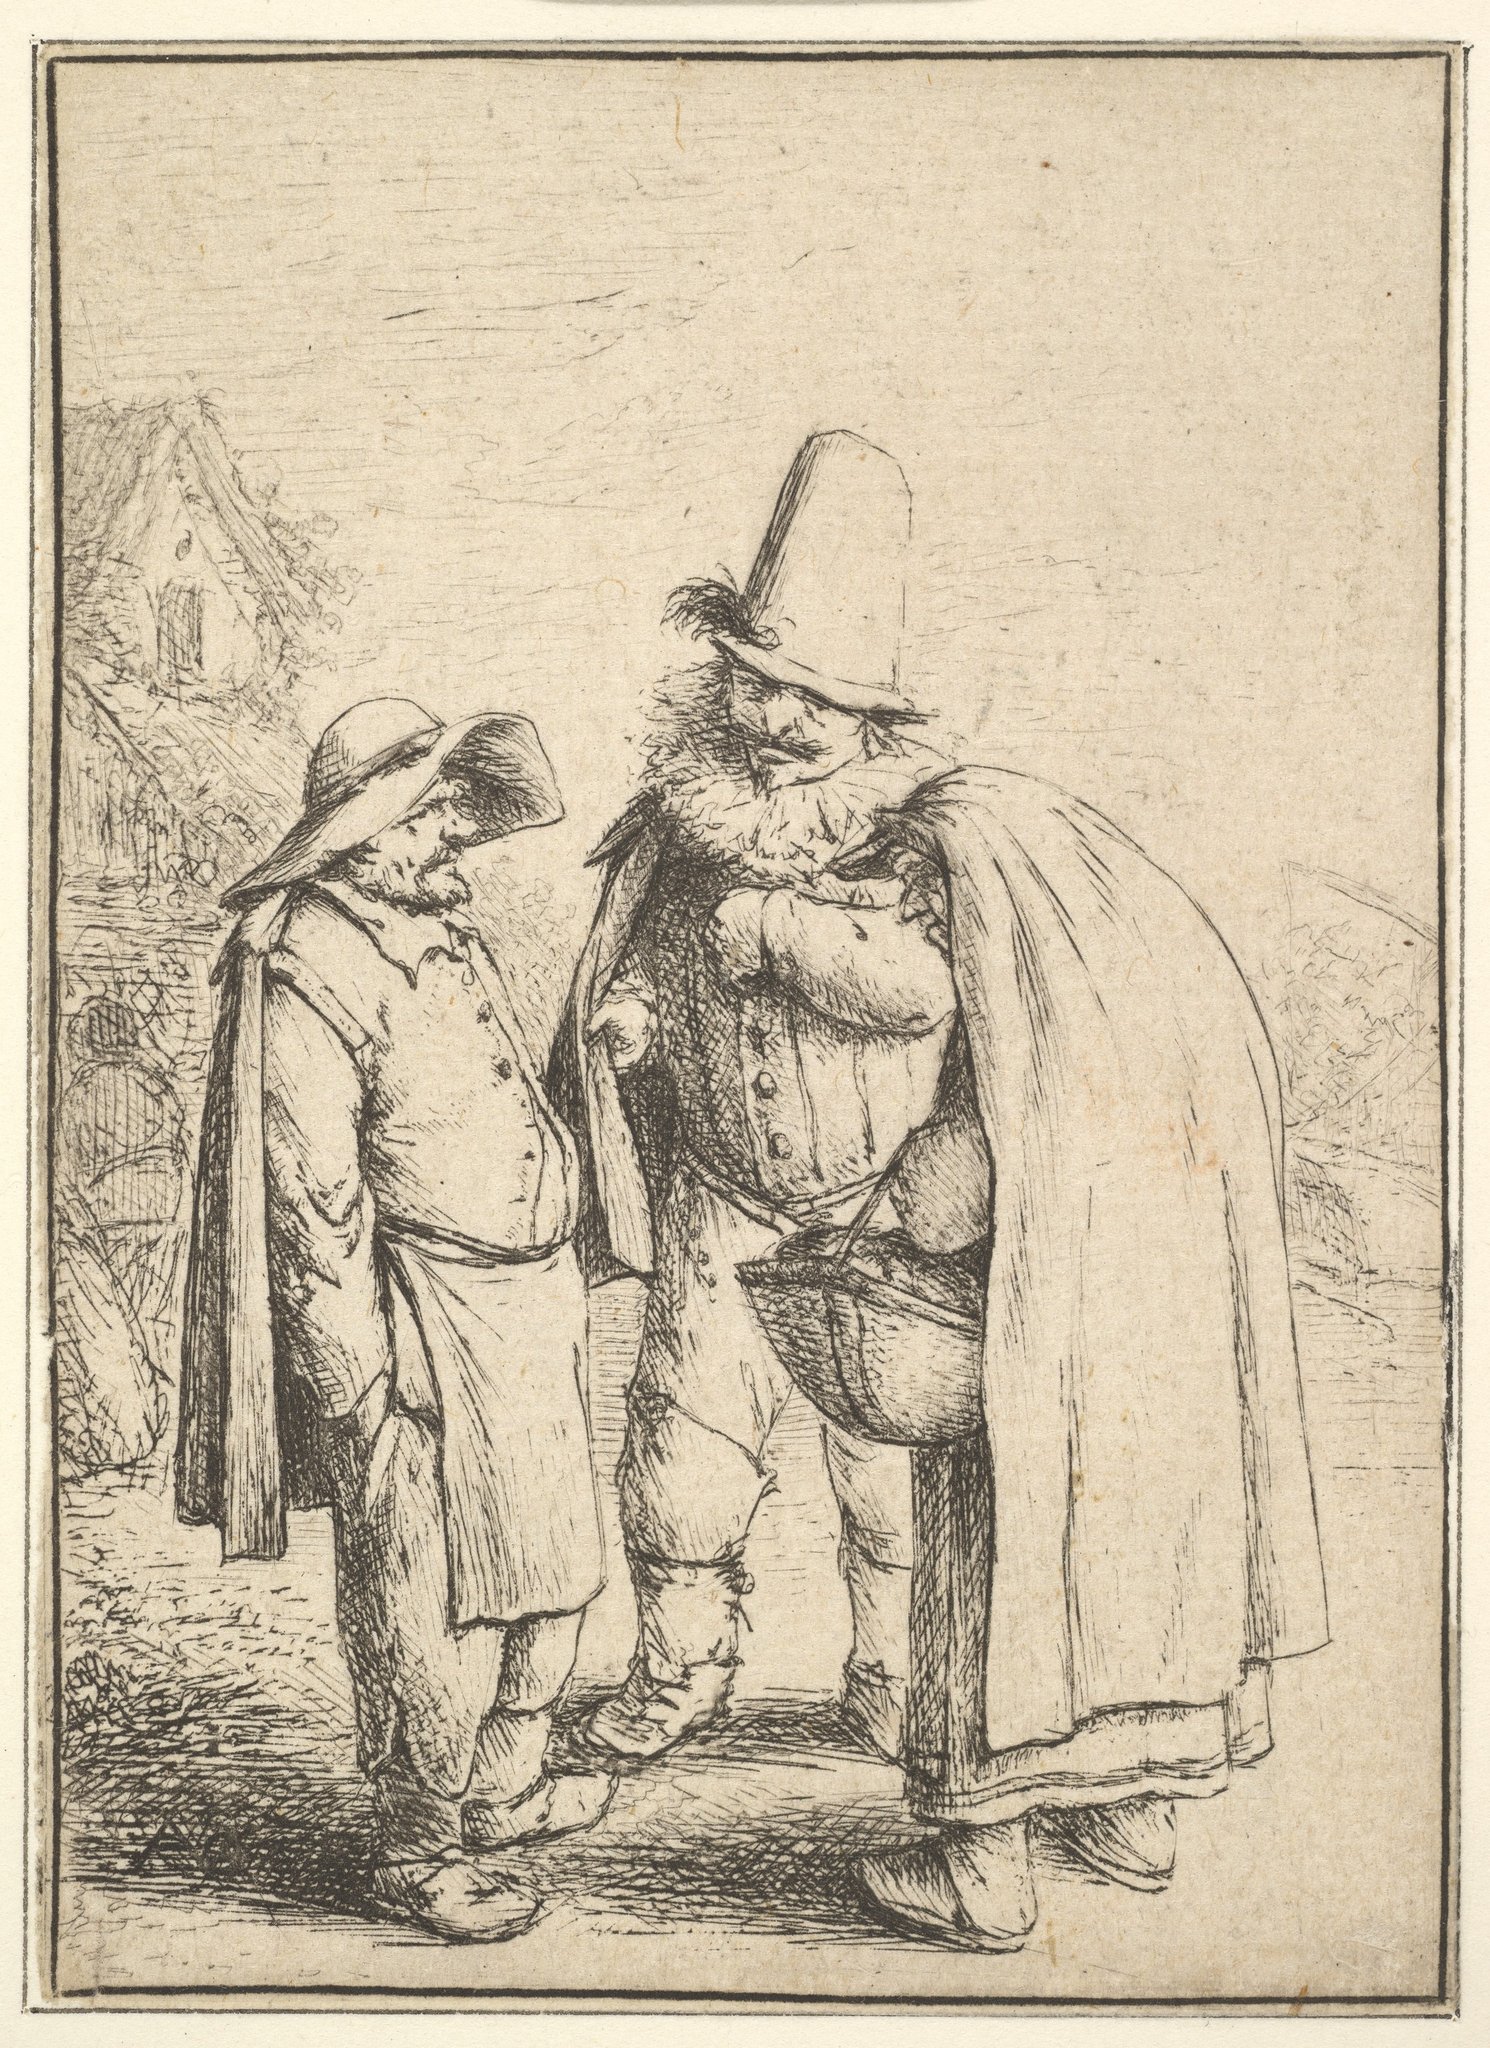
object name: print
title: Grotesque Figures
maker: adriaen van ostade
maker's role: artist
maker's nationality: dutch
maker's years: 1610-1685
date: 1610-1685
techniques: etching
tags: men